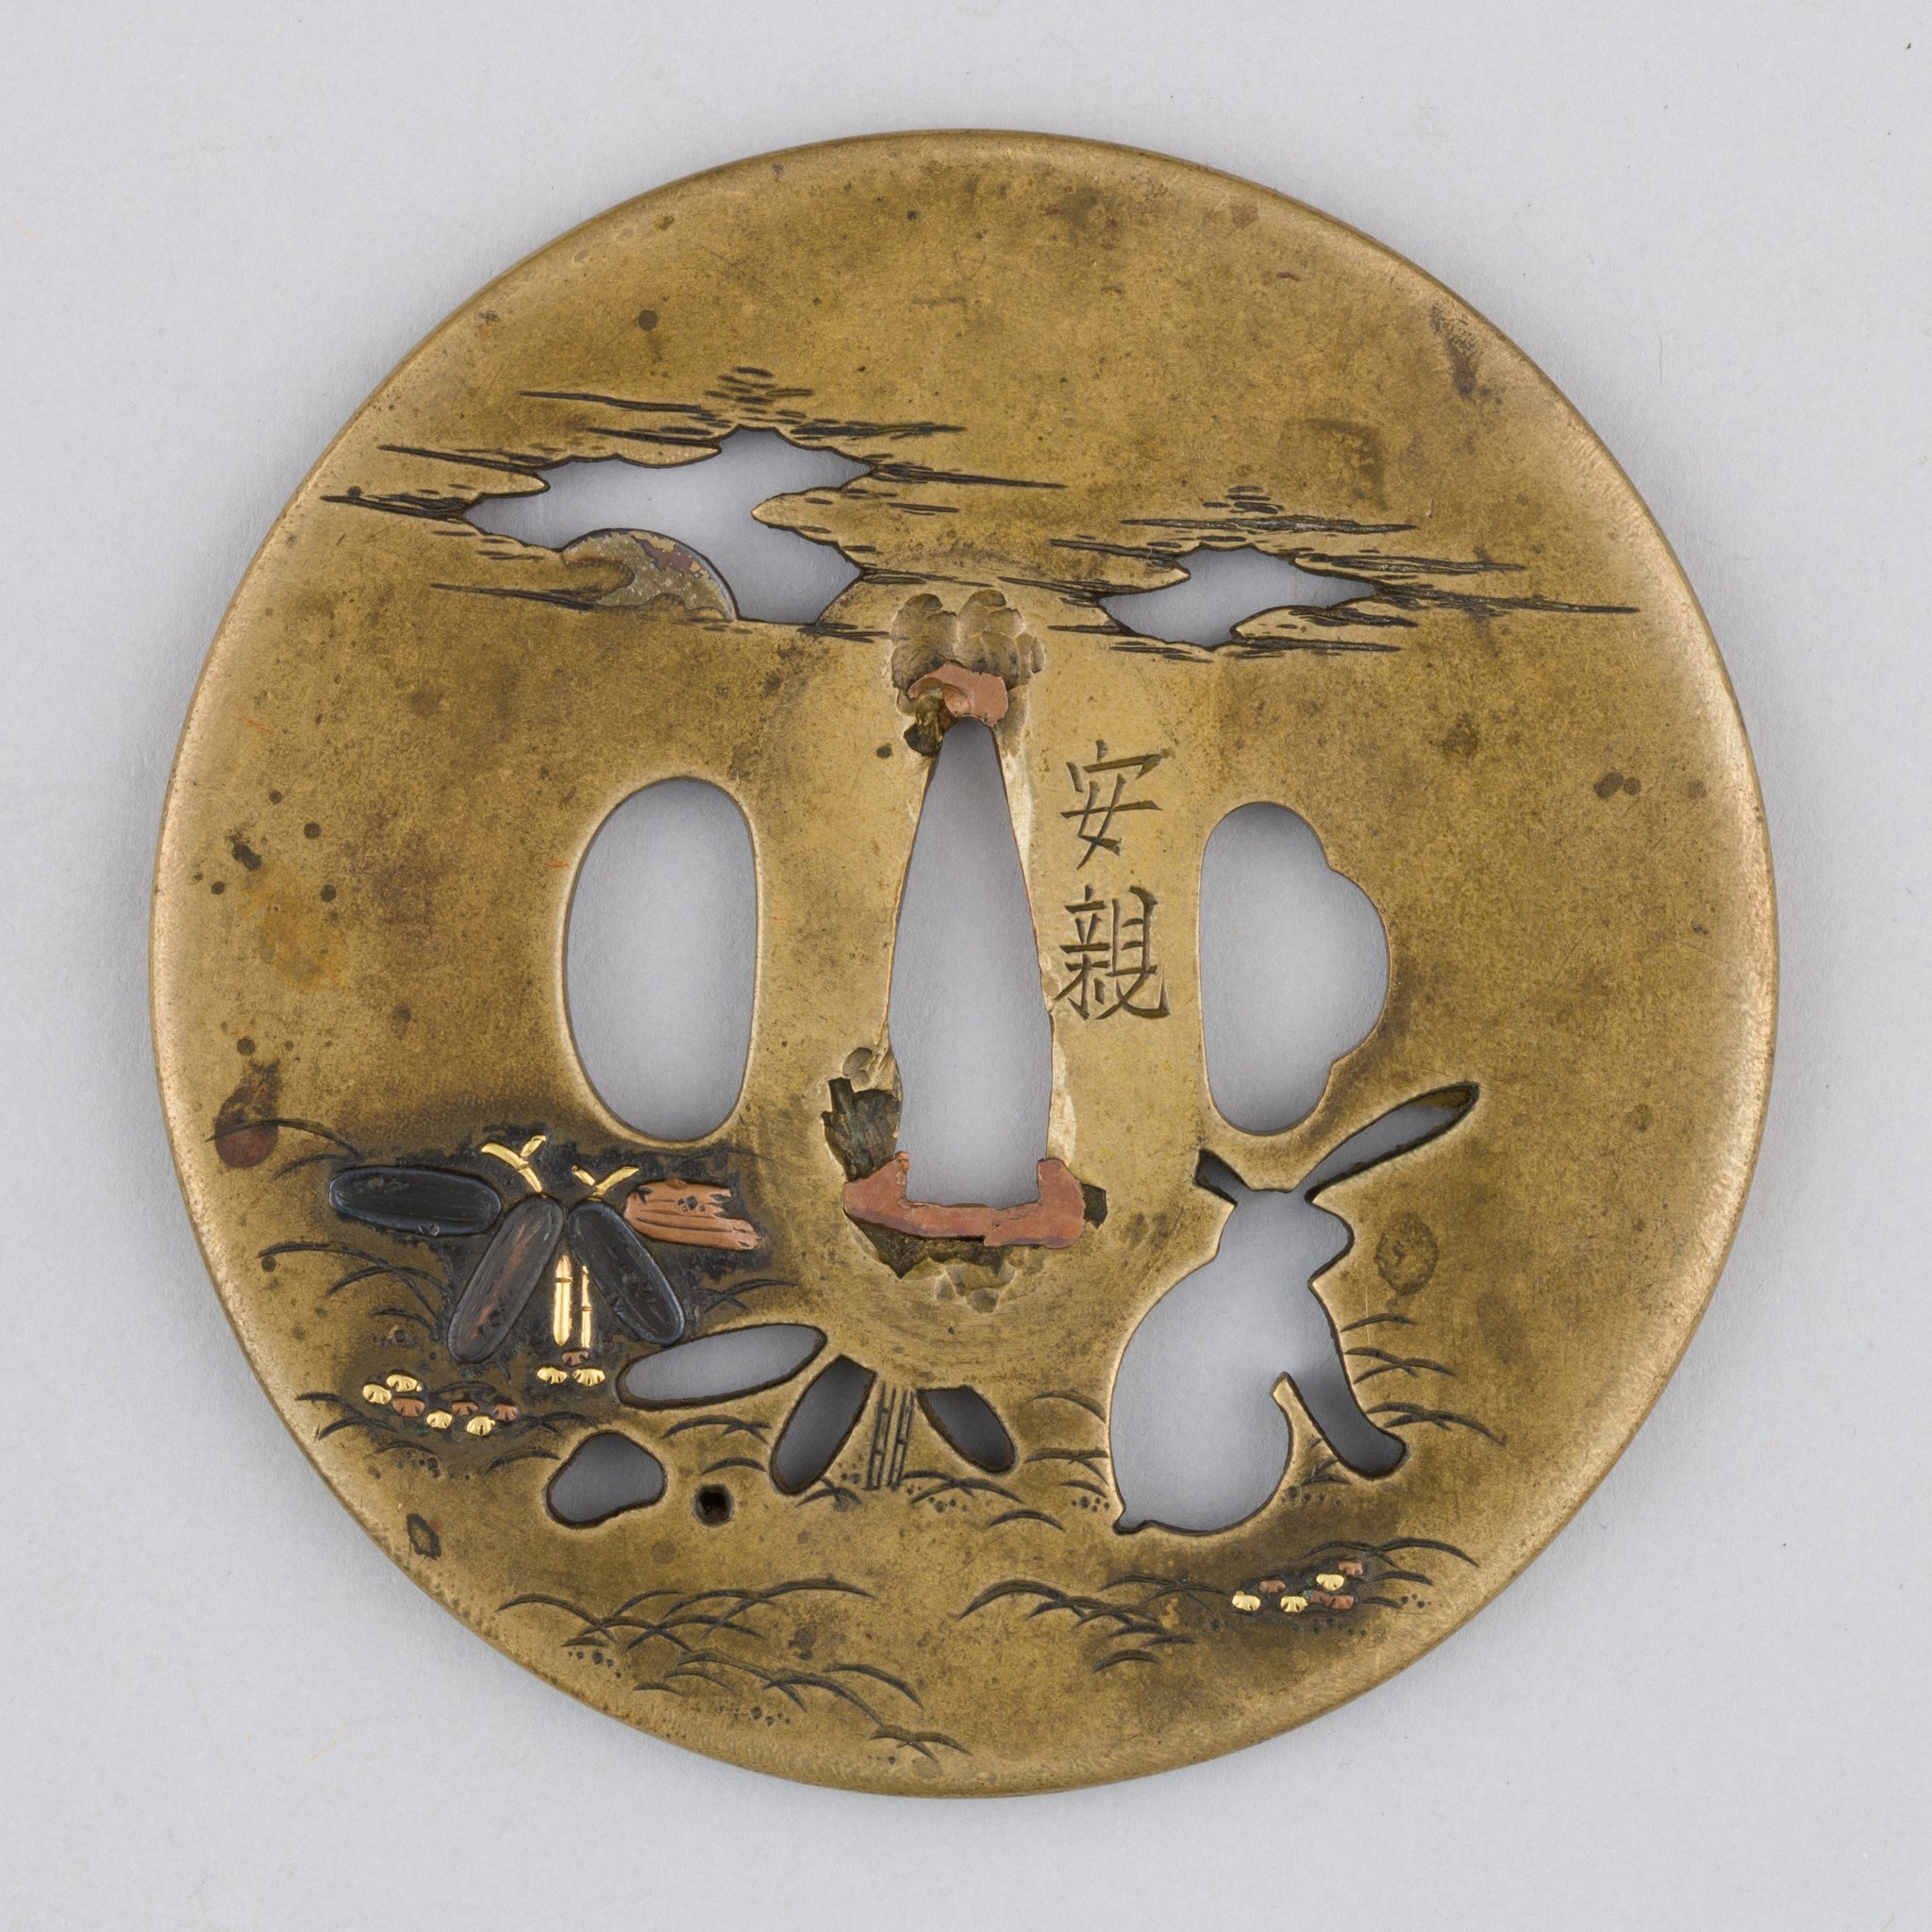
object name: sword guard tsuba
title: Sword Guard (Tsuba)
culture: japanese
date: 1669-1744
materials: copper, copper alloy, gold alloy, silver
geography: japan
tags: rabbits